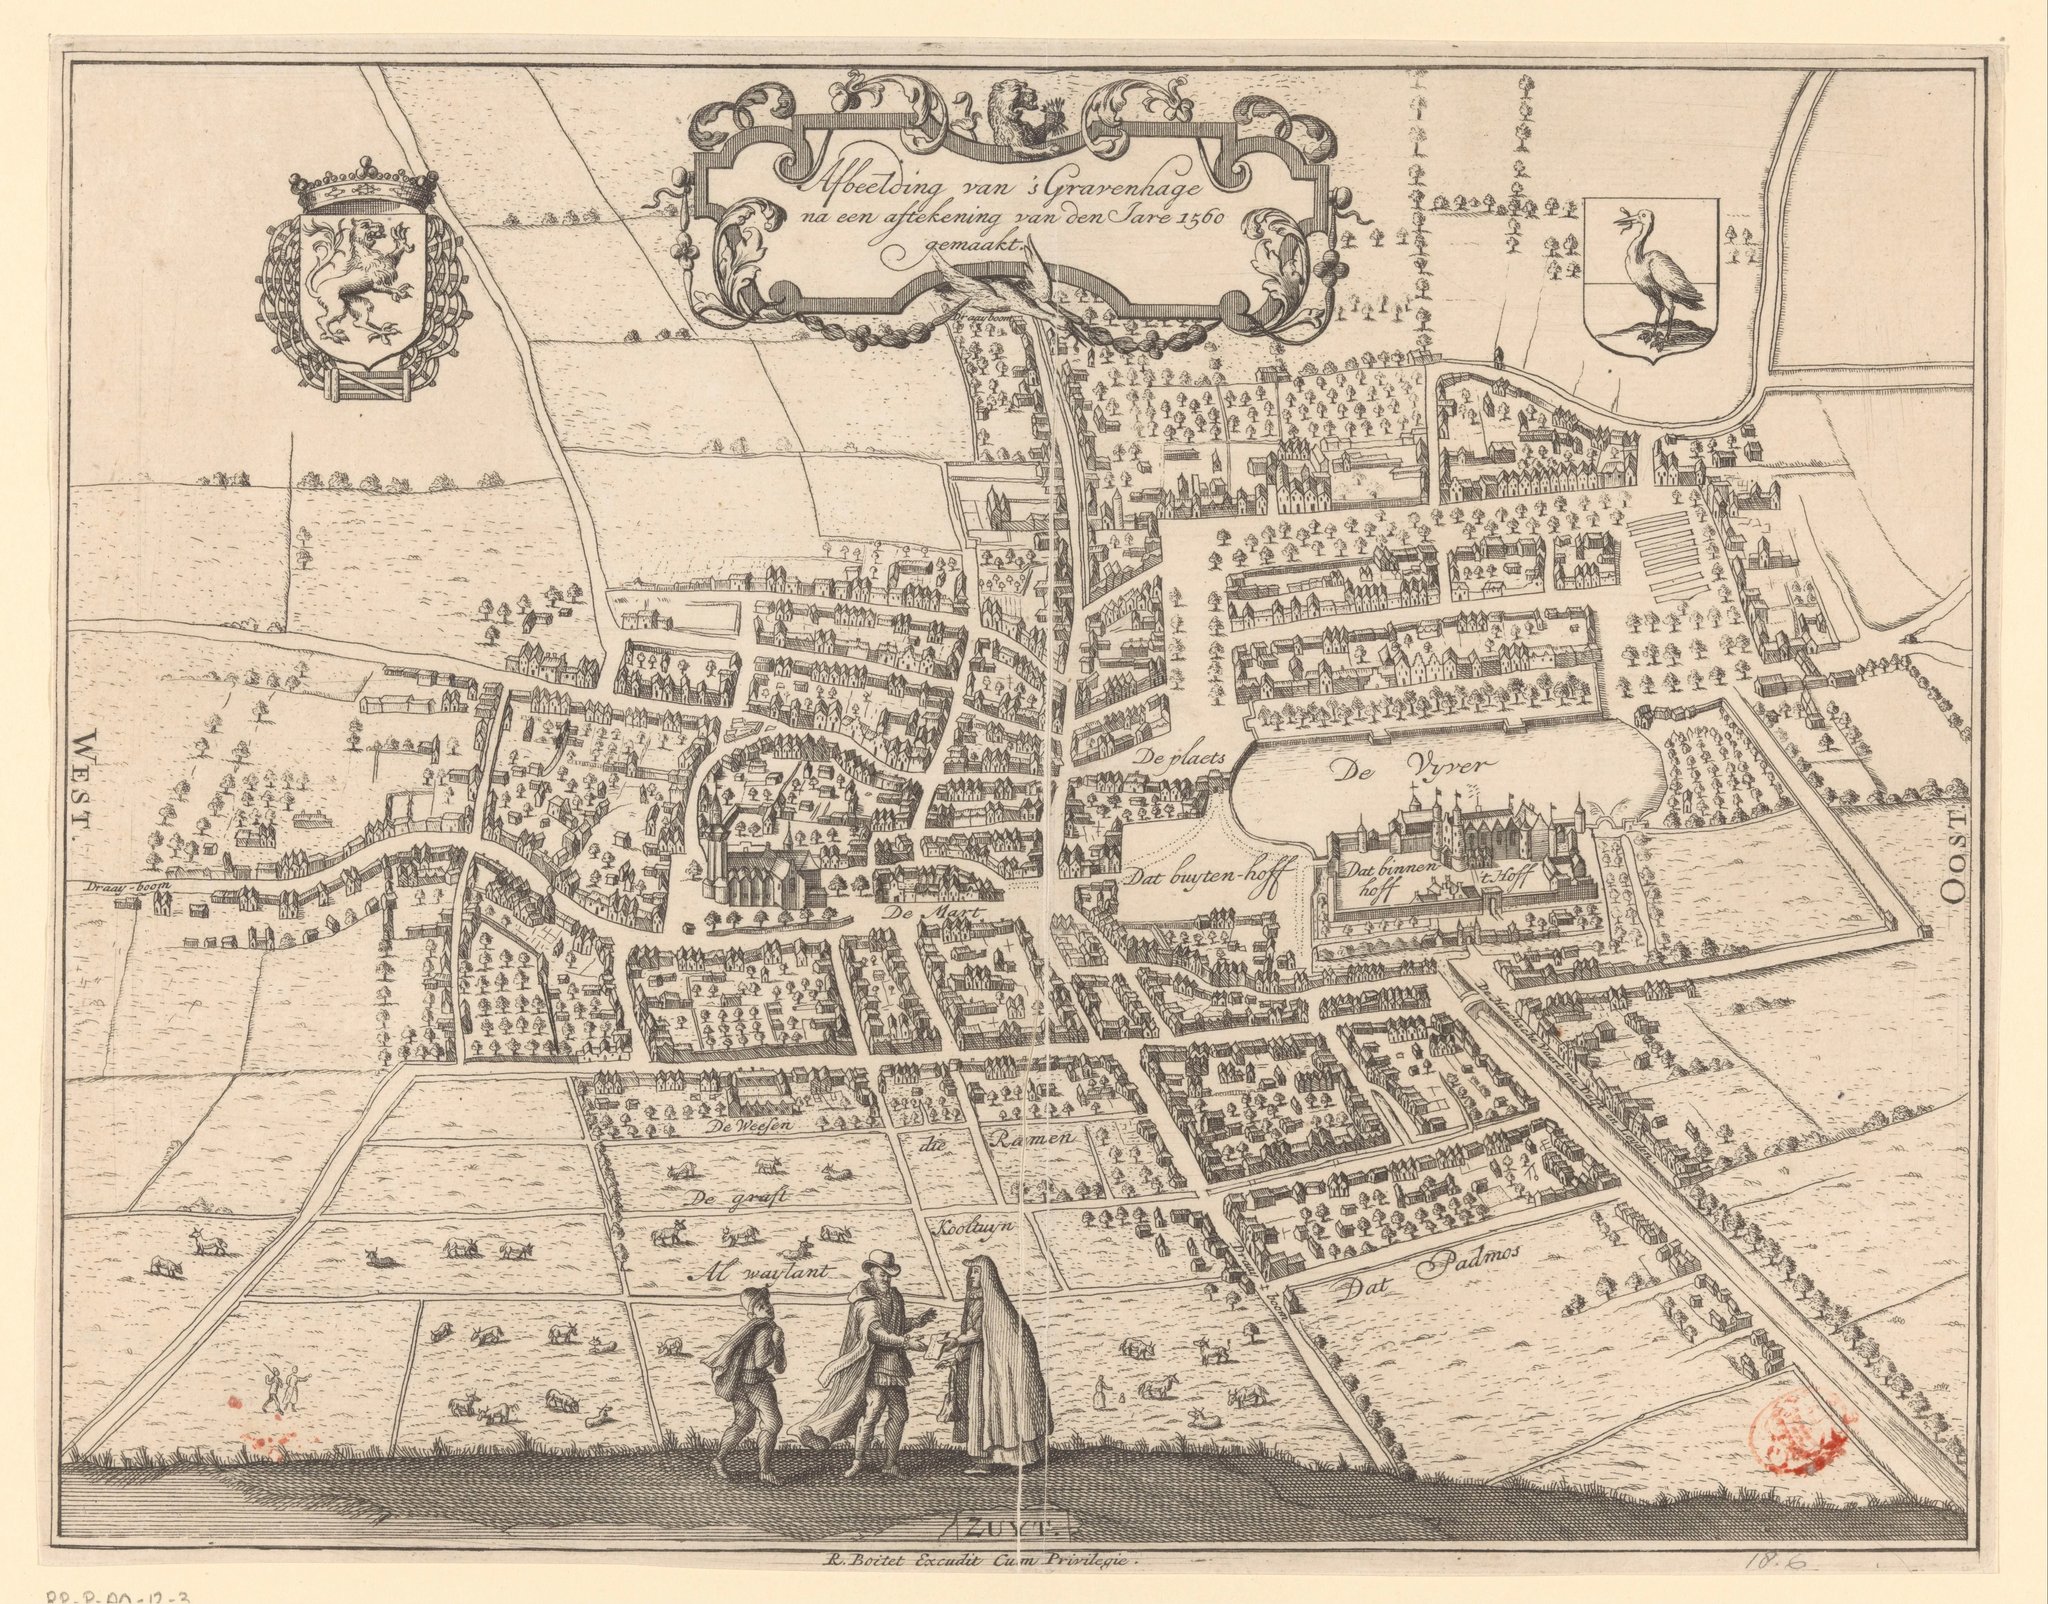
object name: book illustration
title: Afbeelding van 's Gravenhage na een aftekening van den jare 1560 gemaakt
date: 1730-1736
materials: paper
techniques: engraving, etching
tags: coat of arms (as symbol of the state, etc.) (+ city; municipal), maps of cities, coat of arms (as symbol of the state, etc.) (+ province; provincial), the hague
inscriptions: collector's mark: Lugt 195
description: Plattegrond van Den Haag in 1560, in vogelvluchtperspectief. Linksboven het wapen van Holland, boven in het midden de titelcartouche, rechtsboven het wapen van Den Haag. Op de voorgrond drie figuren.